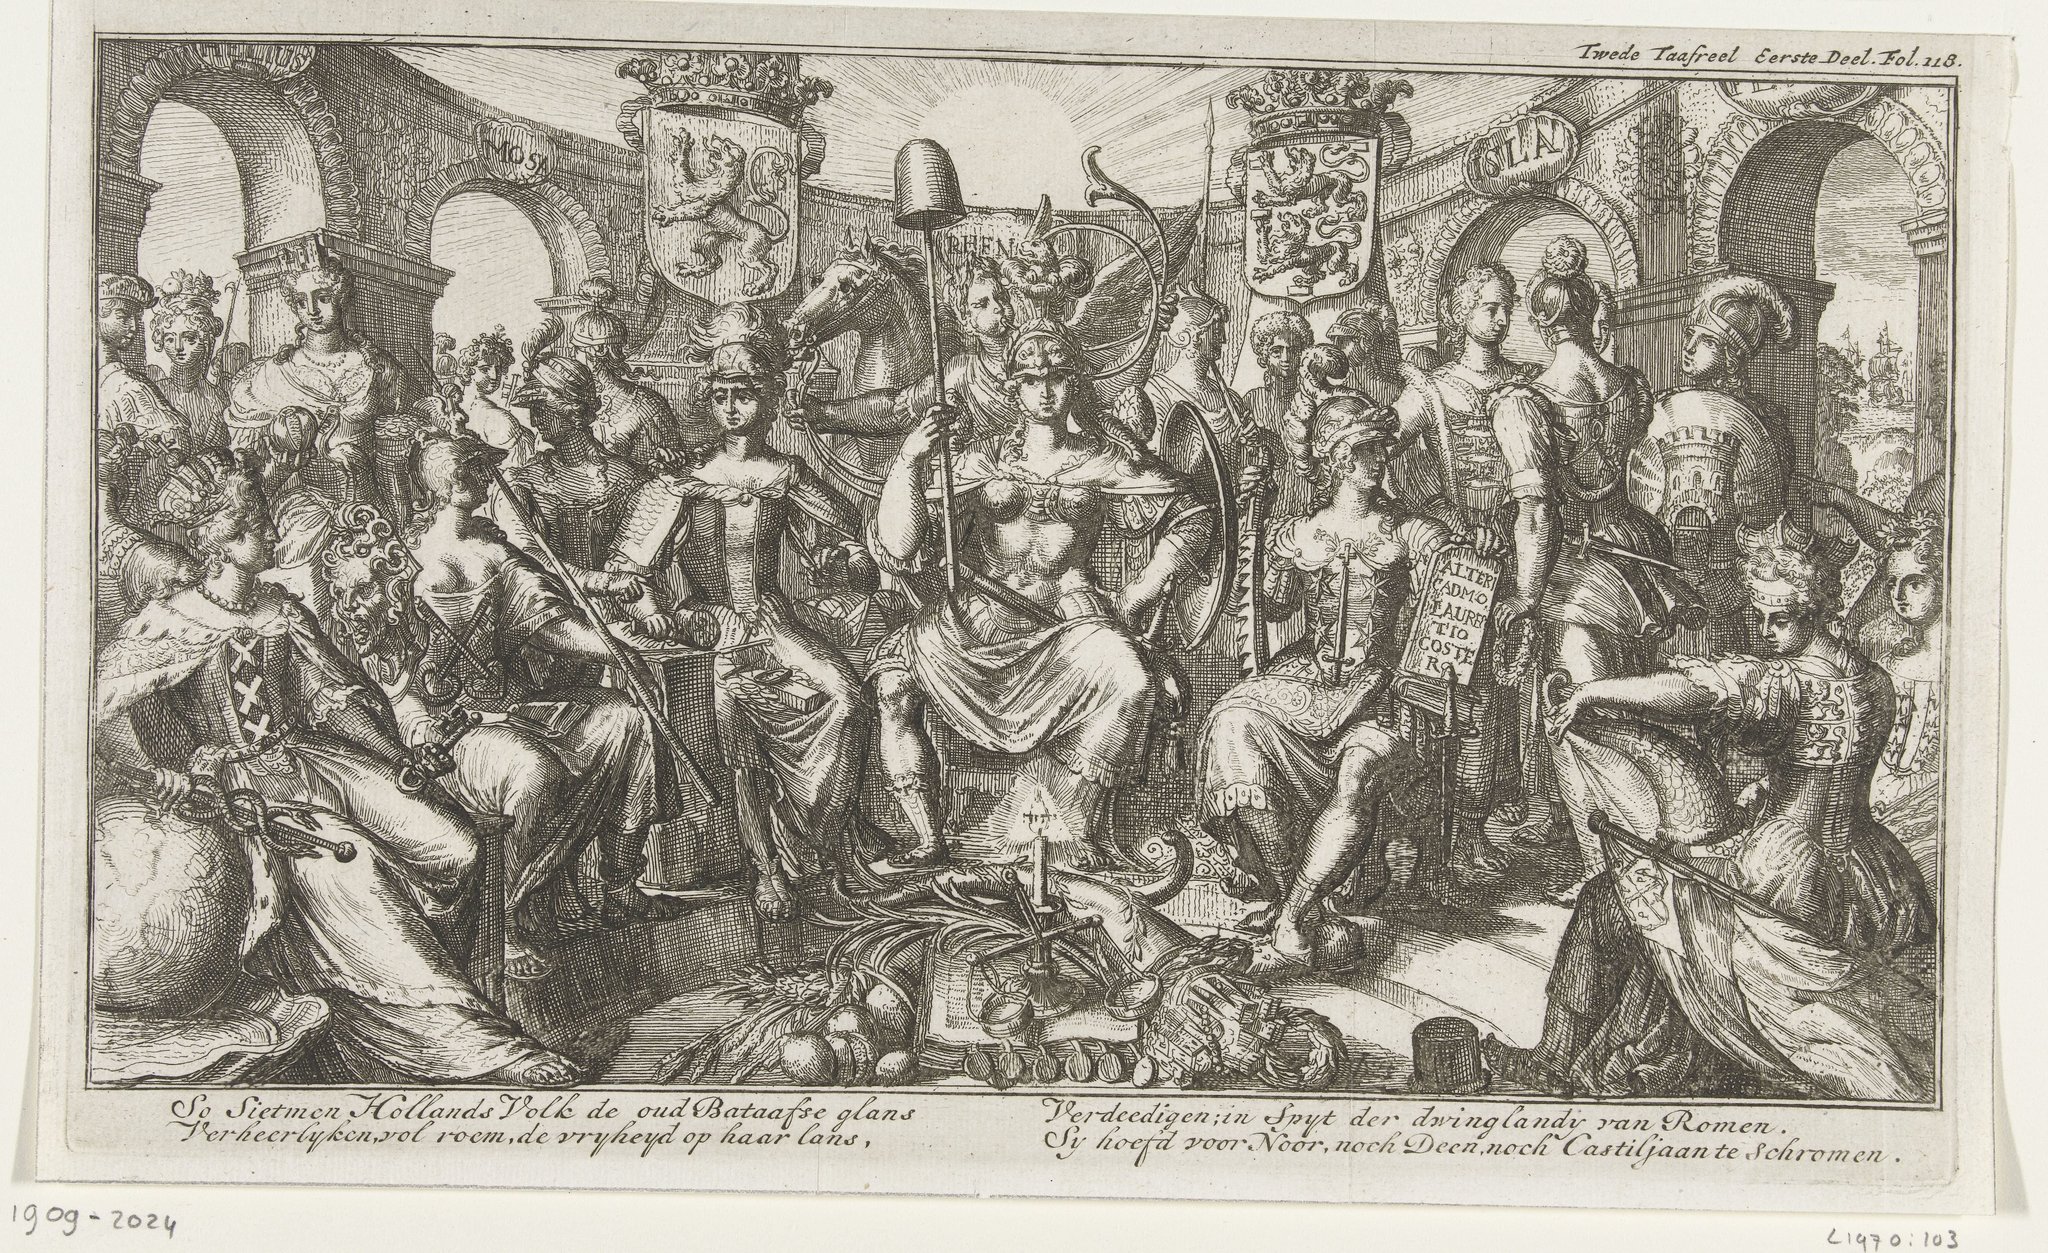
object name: print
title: Allegorie met Holland en West-Friesland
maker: romeyn de hooghe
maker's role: draughtsman, goldsmith, painter, print maker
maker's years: 1645-1708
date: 1704-1706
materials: paper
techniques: etching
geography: netherlands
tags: personifications of countries, nations, states, districts, etc., holland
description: Illustratie voor: R. de Hooghe, Spiegel van staat des Vereenigde Nederlands, J. ten Hoorn, Amsterdam 1706, dl. I, tweede tafereel, p. 118.